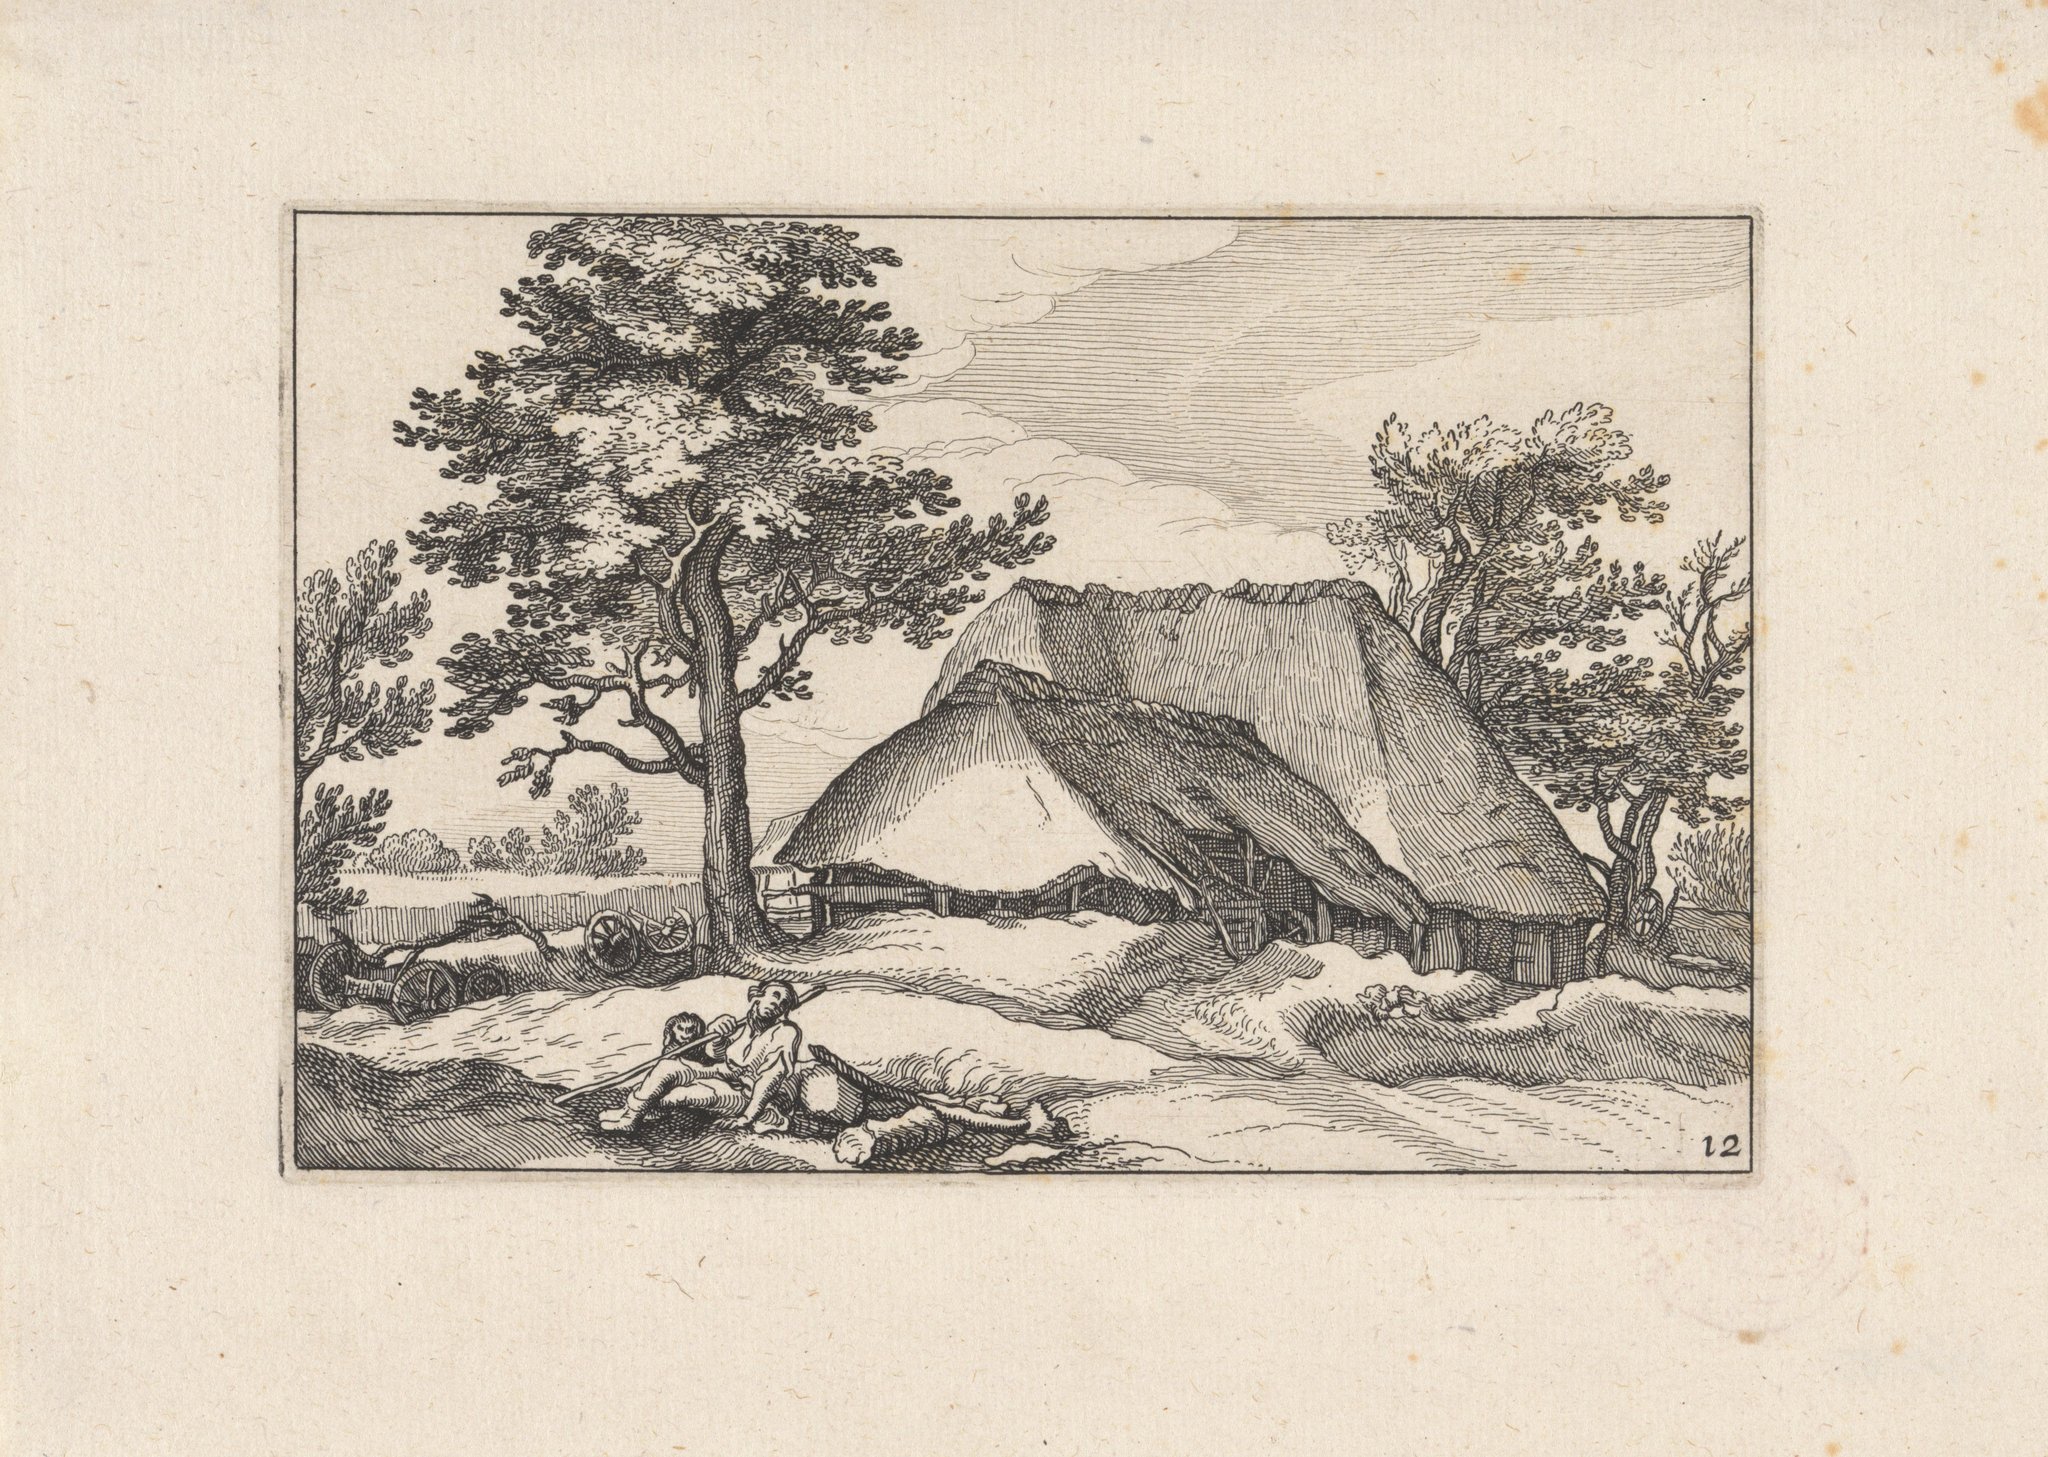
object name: print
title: Boerderij en herder met zijn hond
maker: claes jansz. visscher (ii)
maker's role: draughtsman, print maker, publisher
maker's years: 1586-1652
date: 1620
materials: paper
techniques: etching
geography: amsterdam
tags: herding, herdsman, herdswoman, shepherd, shepherdess, cowherd, etc., farm (building), dog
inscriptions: collector's mark: Lugt 240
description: Gezicht op een landschap met een boerenhoeve met op de voorgrond een herder met zijn hond. Links op de achtergrond een veld met koren.